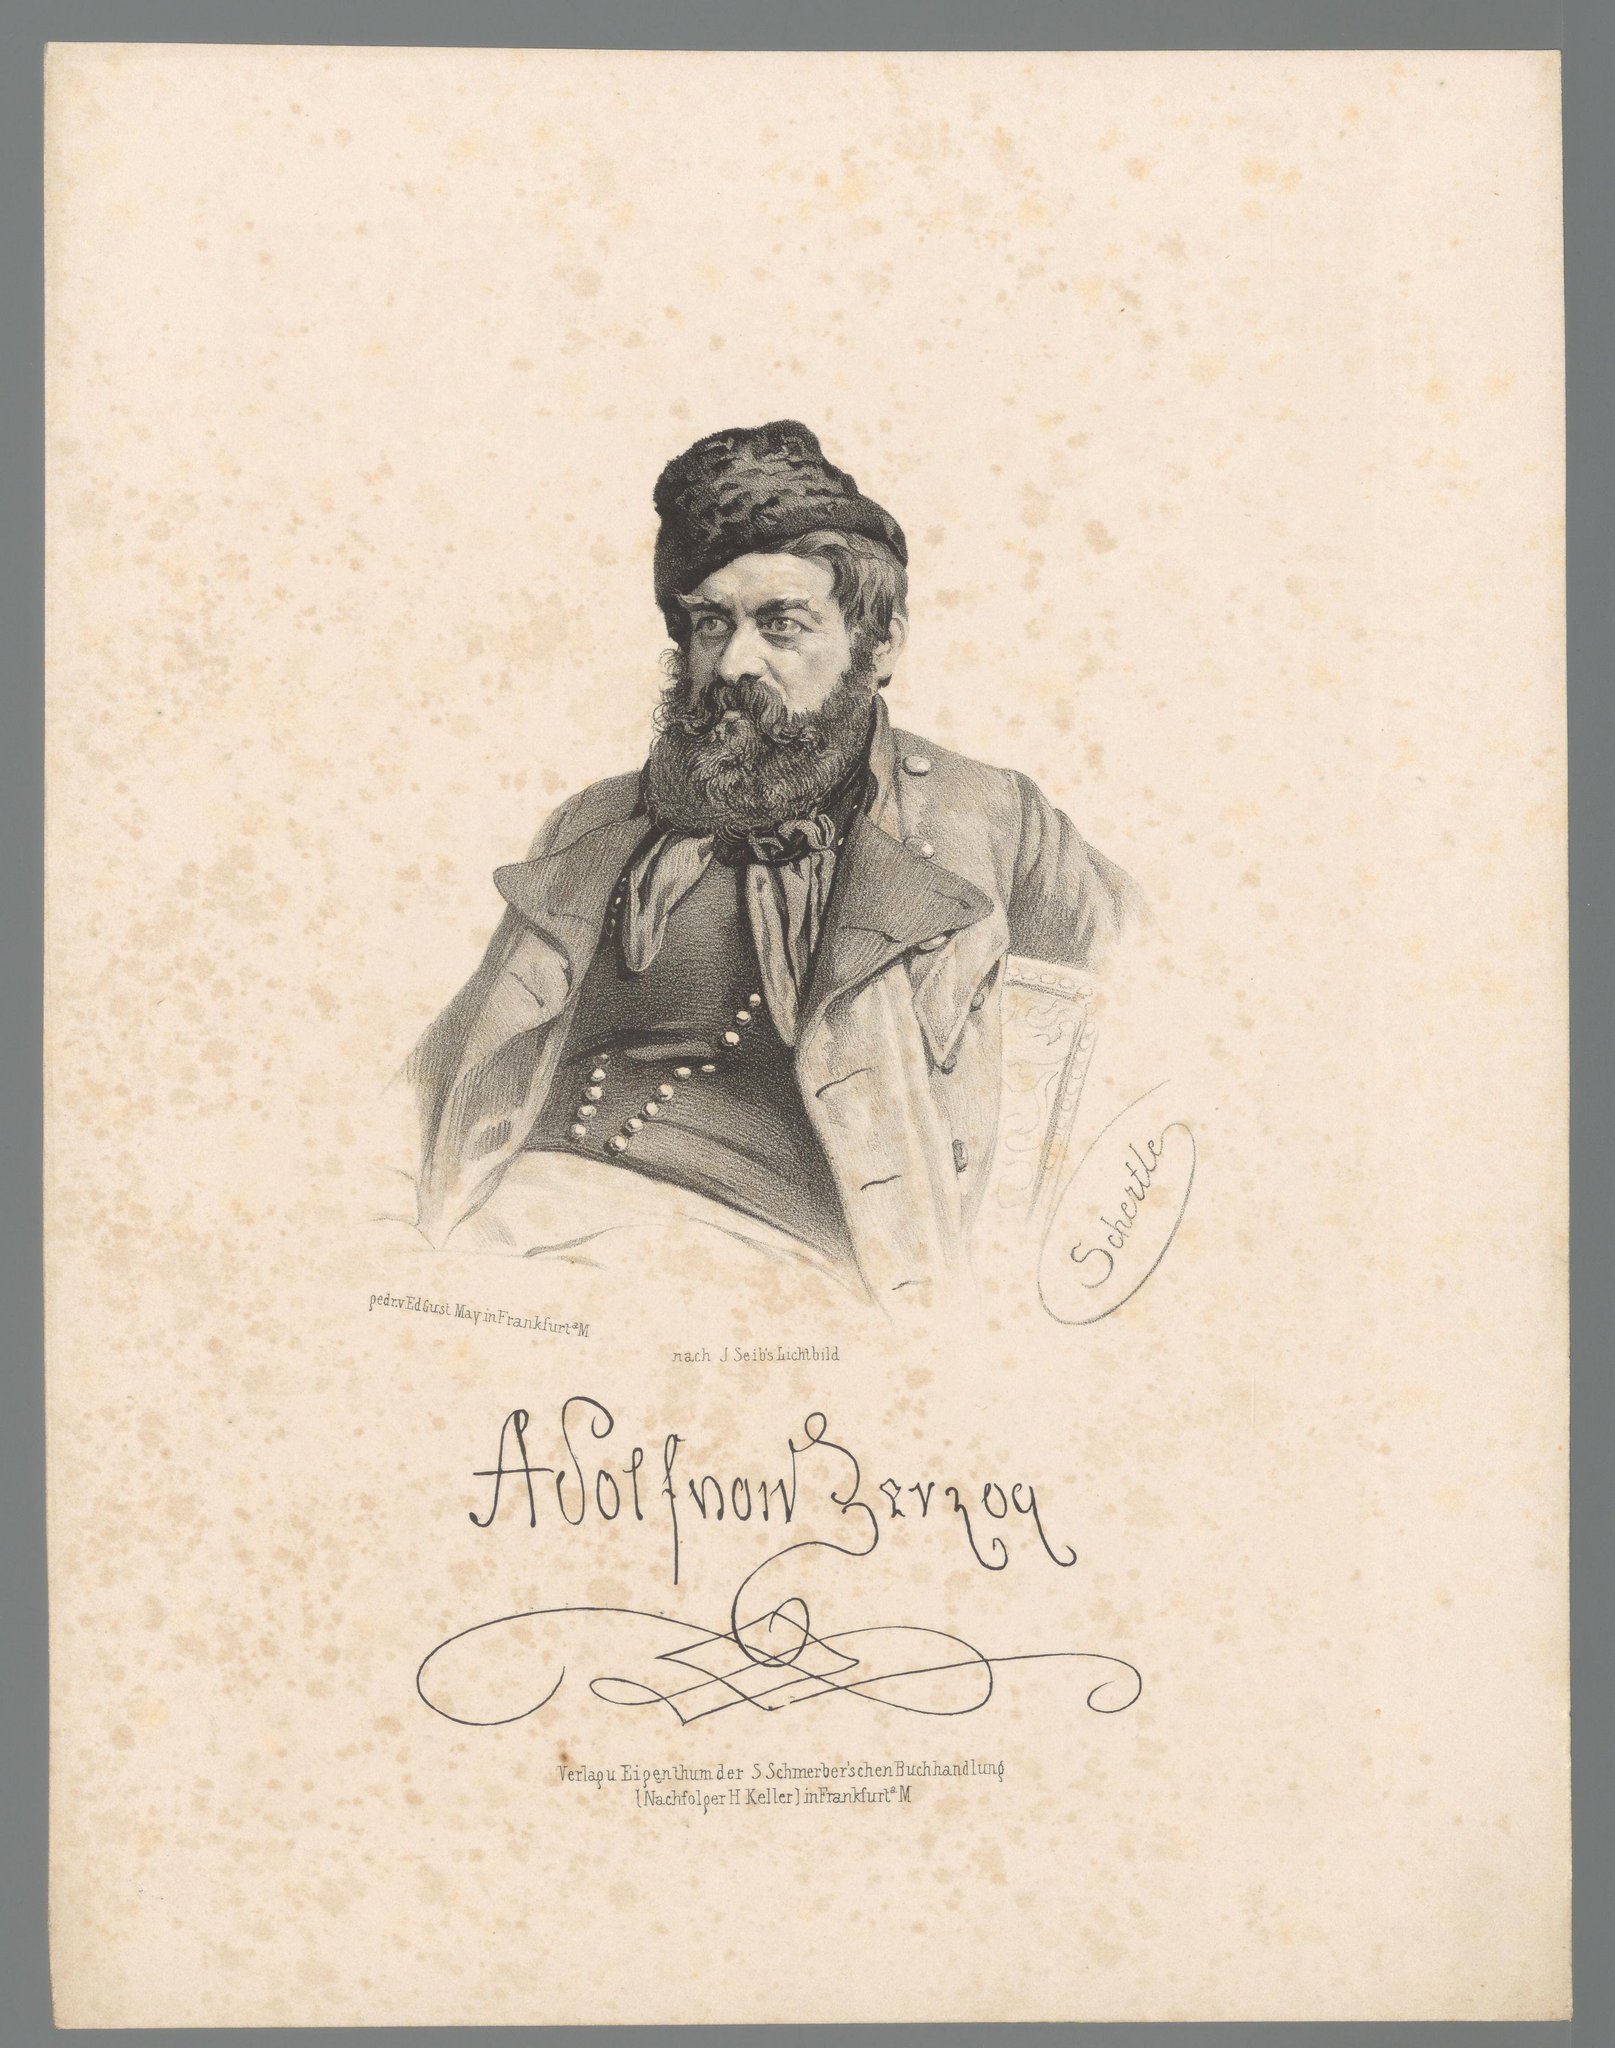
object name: print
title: Die Männer des deutschen Volks, besonders nach Biows Lichtbildern auf Stein gezeichnet von Schertle und Hickmann, oder Deutsche National-Gallerie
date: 1848-1849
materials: paper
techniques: lithograph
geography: frankfurt am main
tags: politician, adult man, historical persons, beard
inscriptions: collector's mark: Lugt 2228